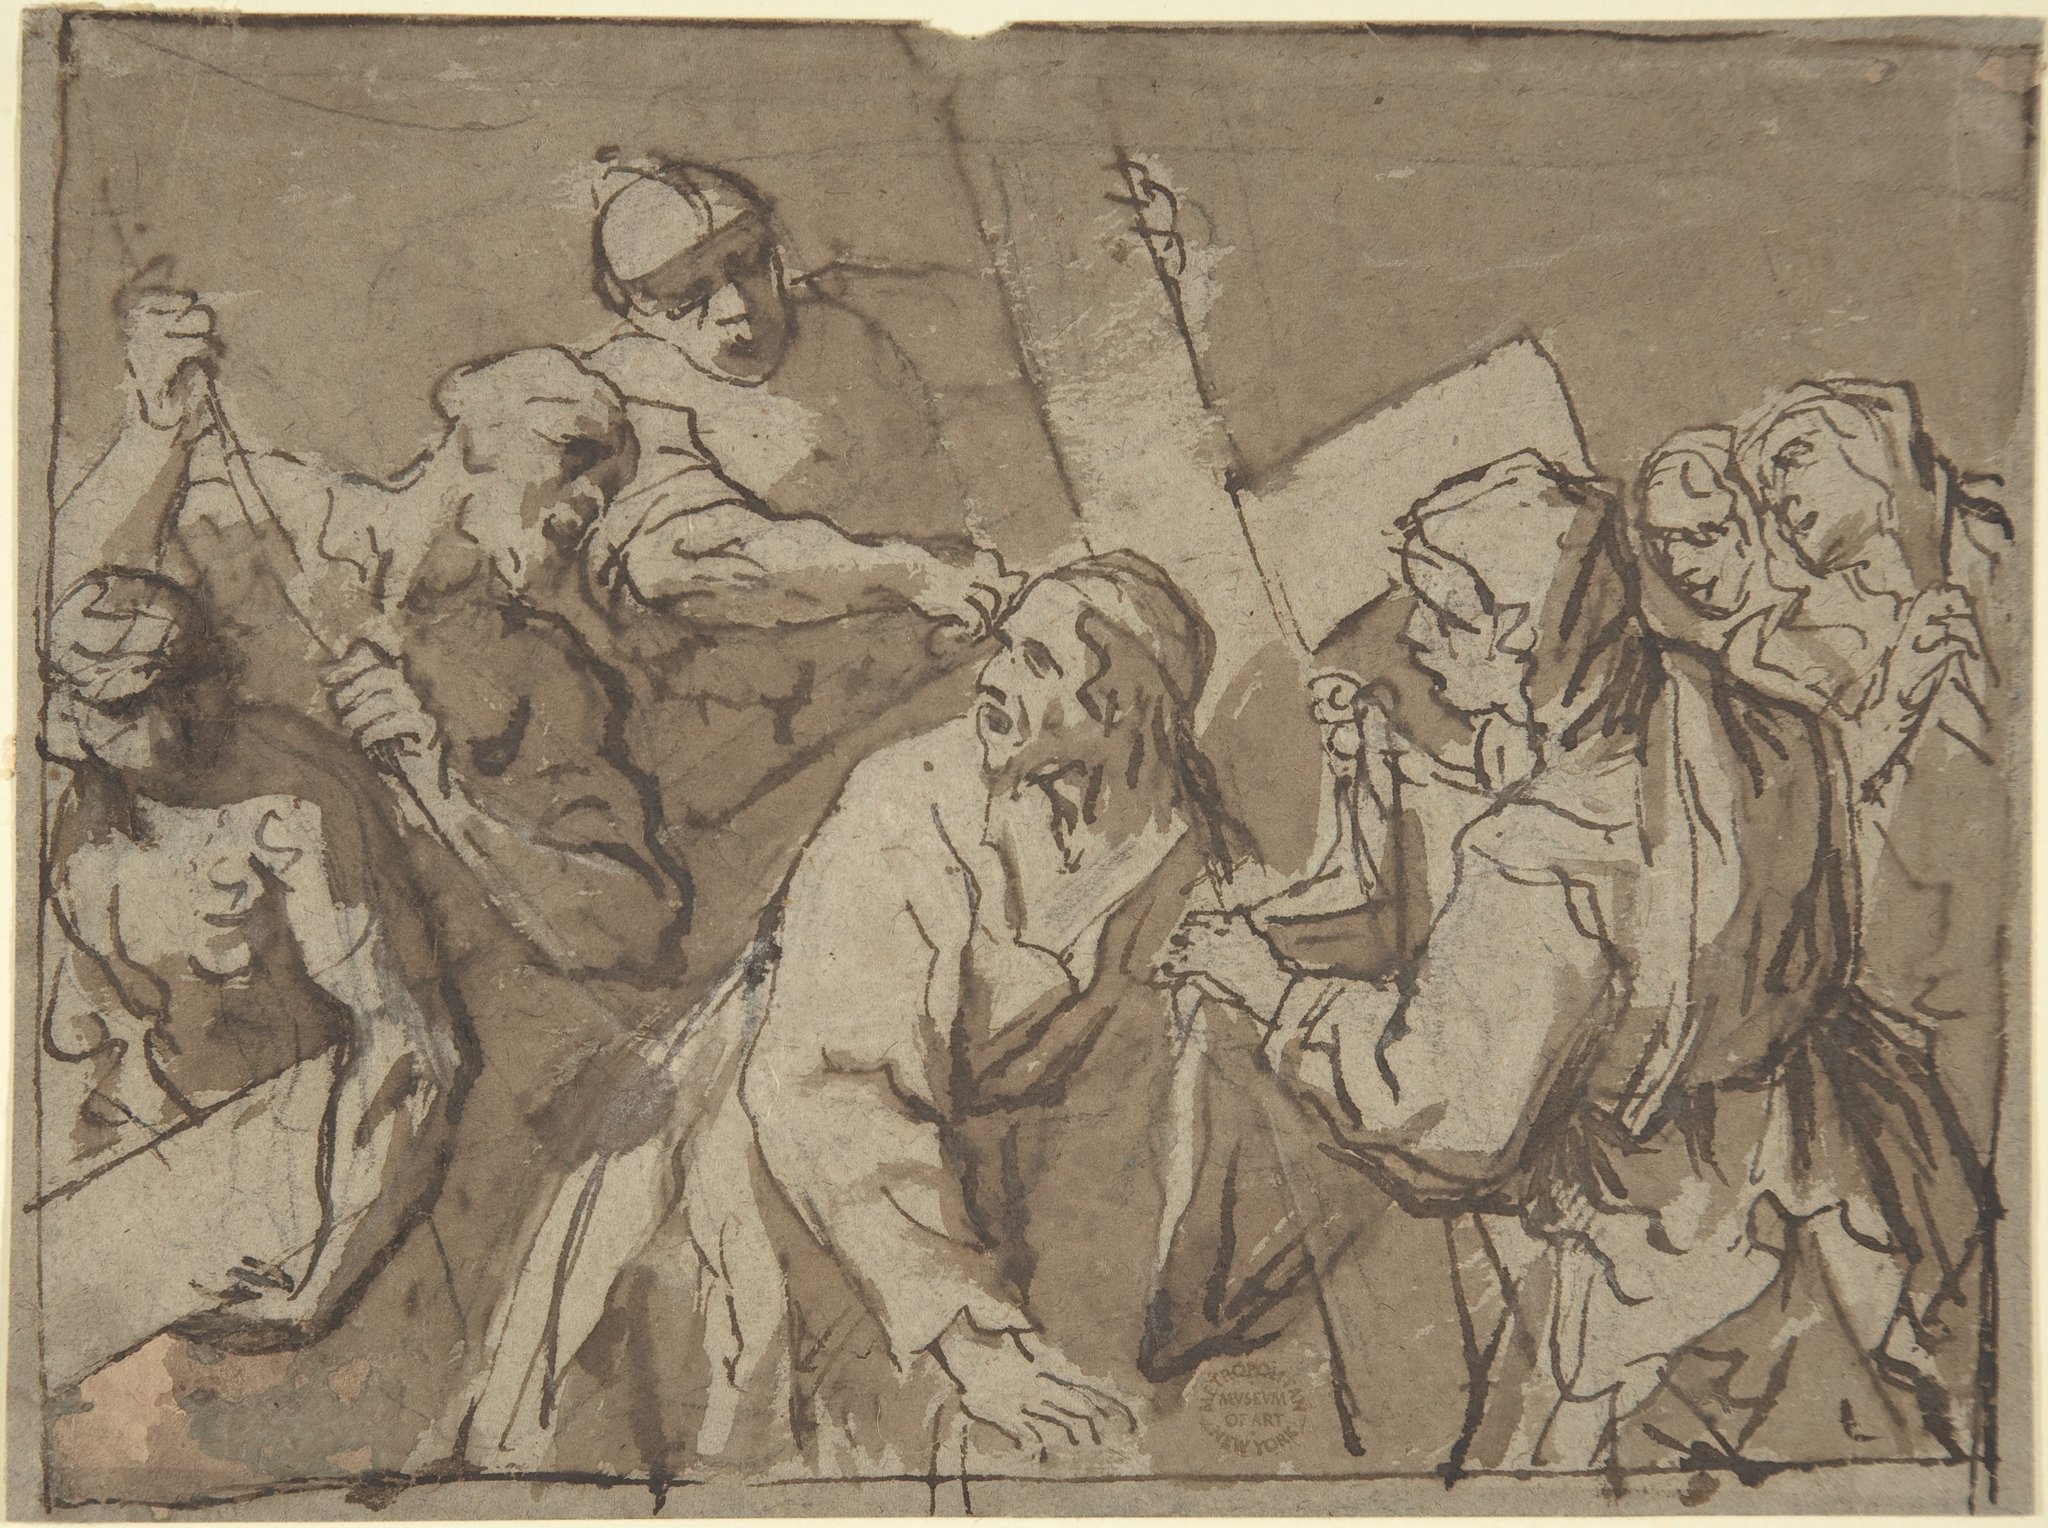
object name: drawing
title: Christ Bearing the Cross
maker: anonymous, italian, roman-bolognese, 17th century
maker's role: artist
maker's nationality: italian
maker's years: 1600-1700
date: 1601-1700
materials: chalk, ink, paper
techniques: brush, pen, wash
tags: men,christ,cross